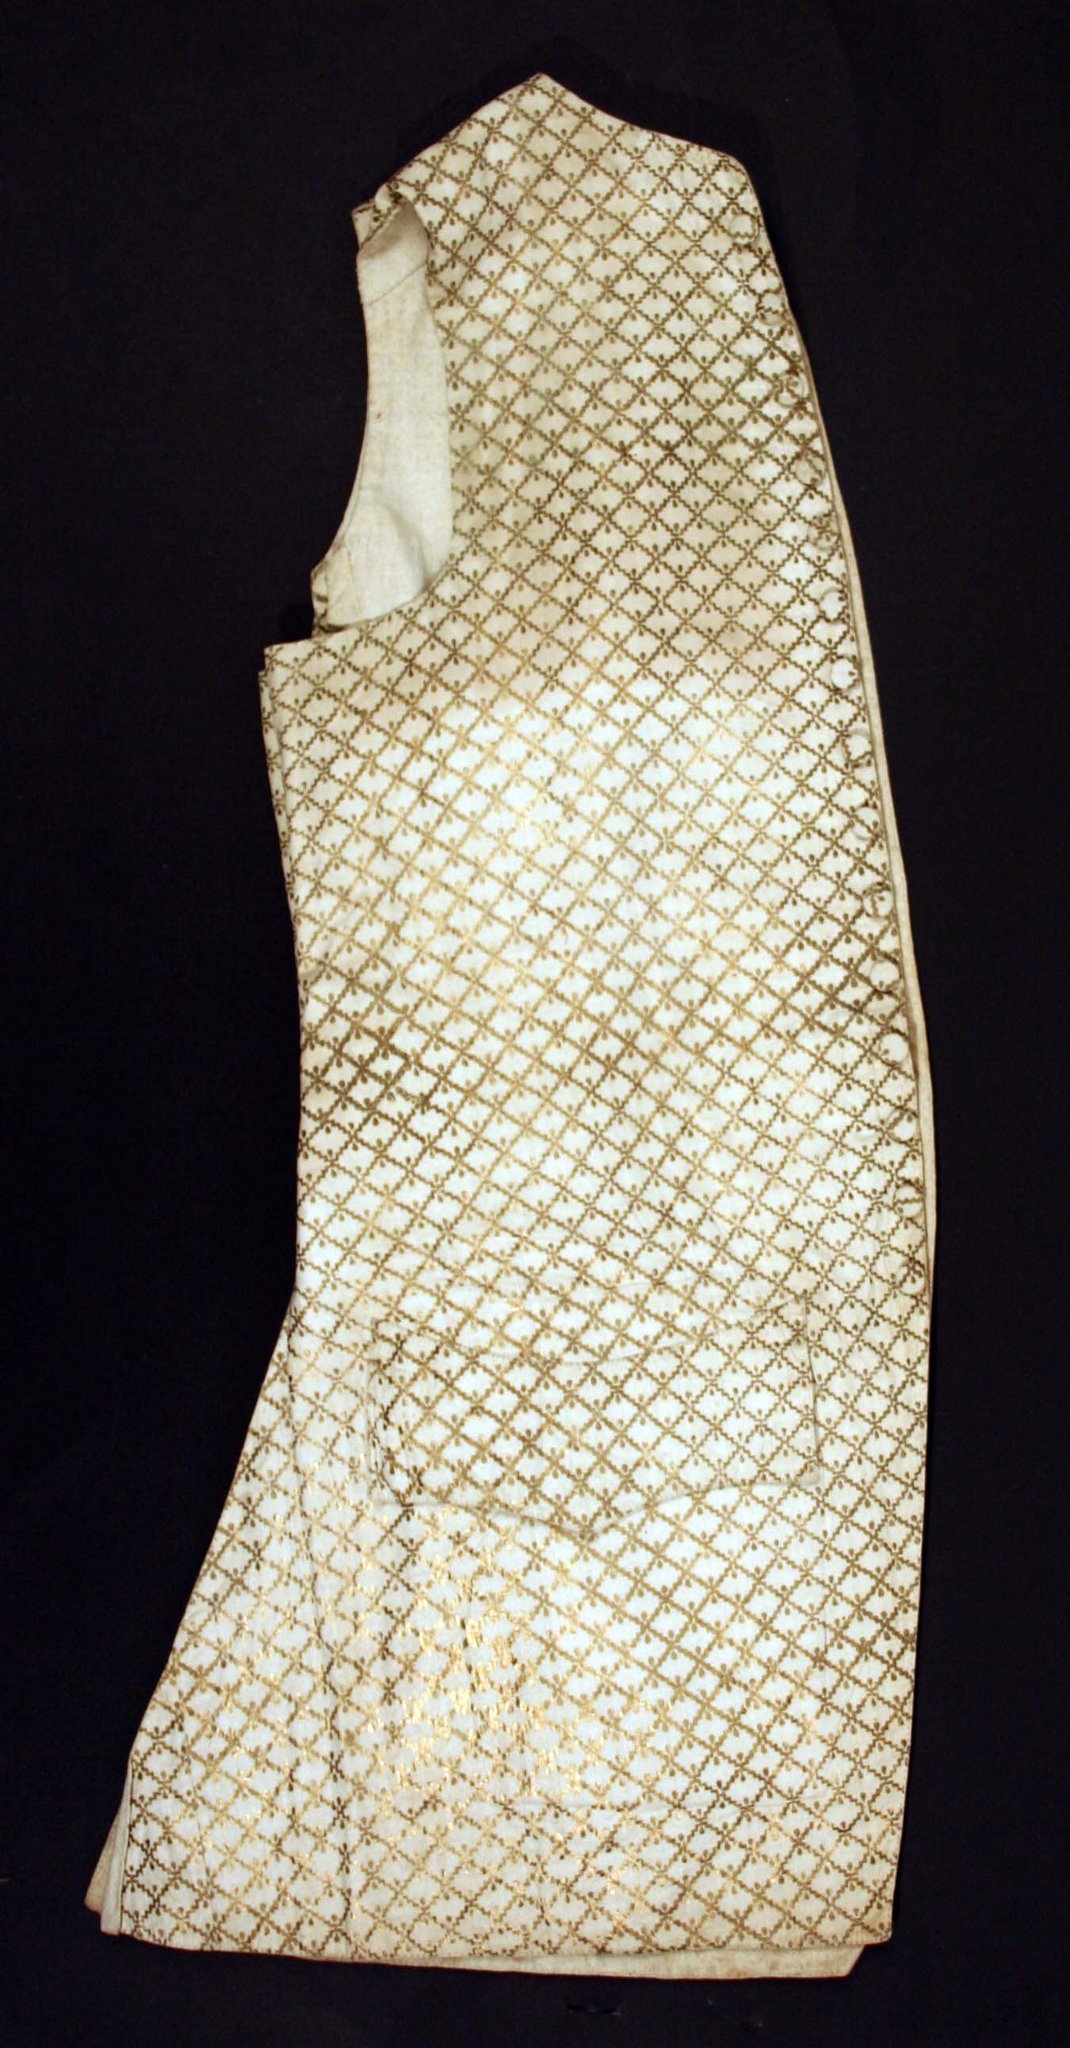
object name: waistcoat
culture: british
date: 1775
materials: cotton